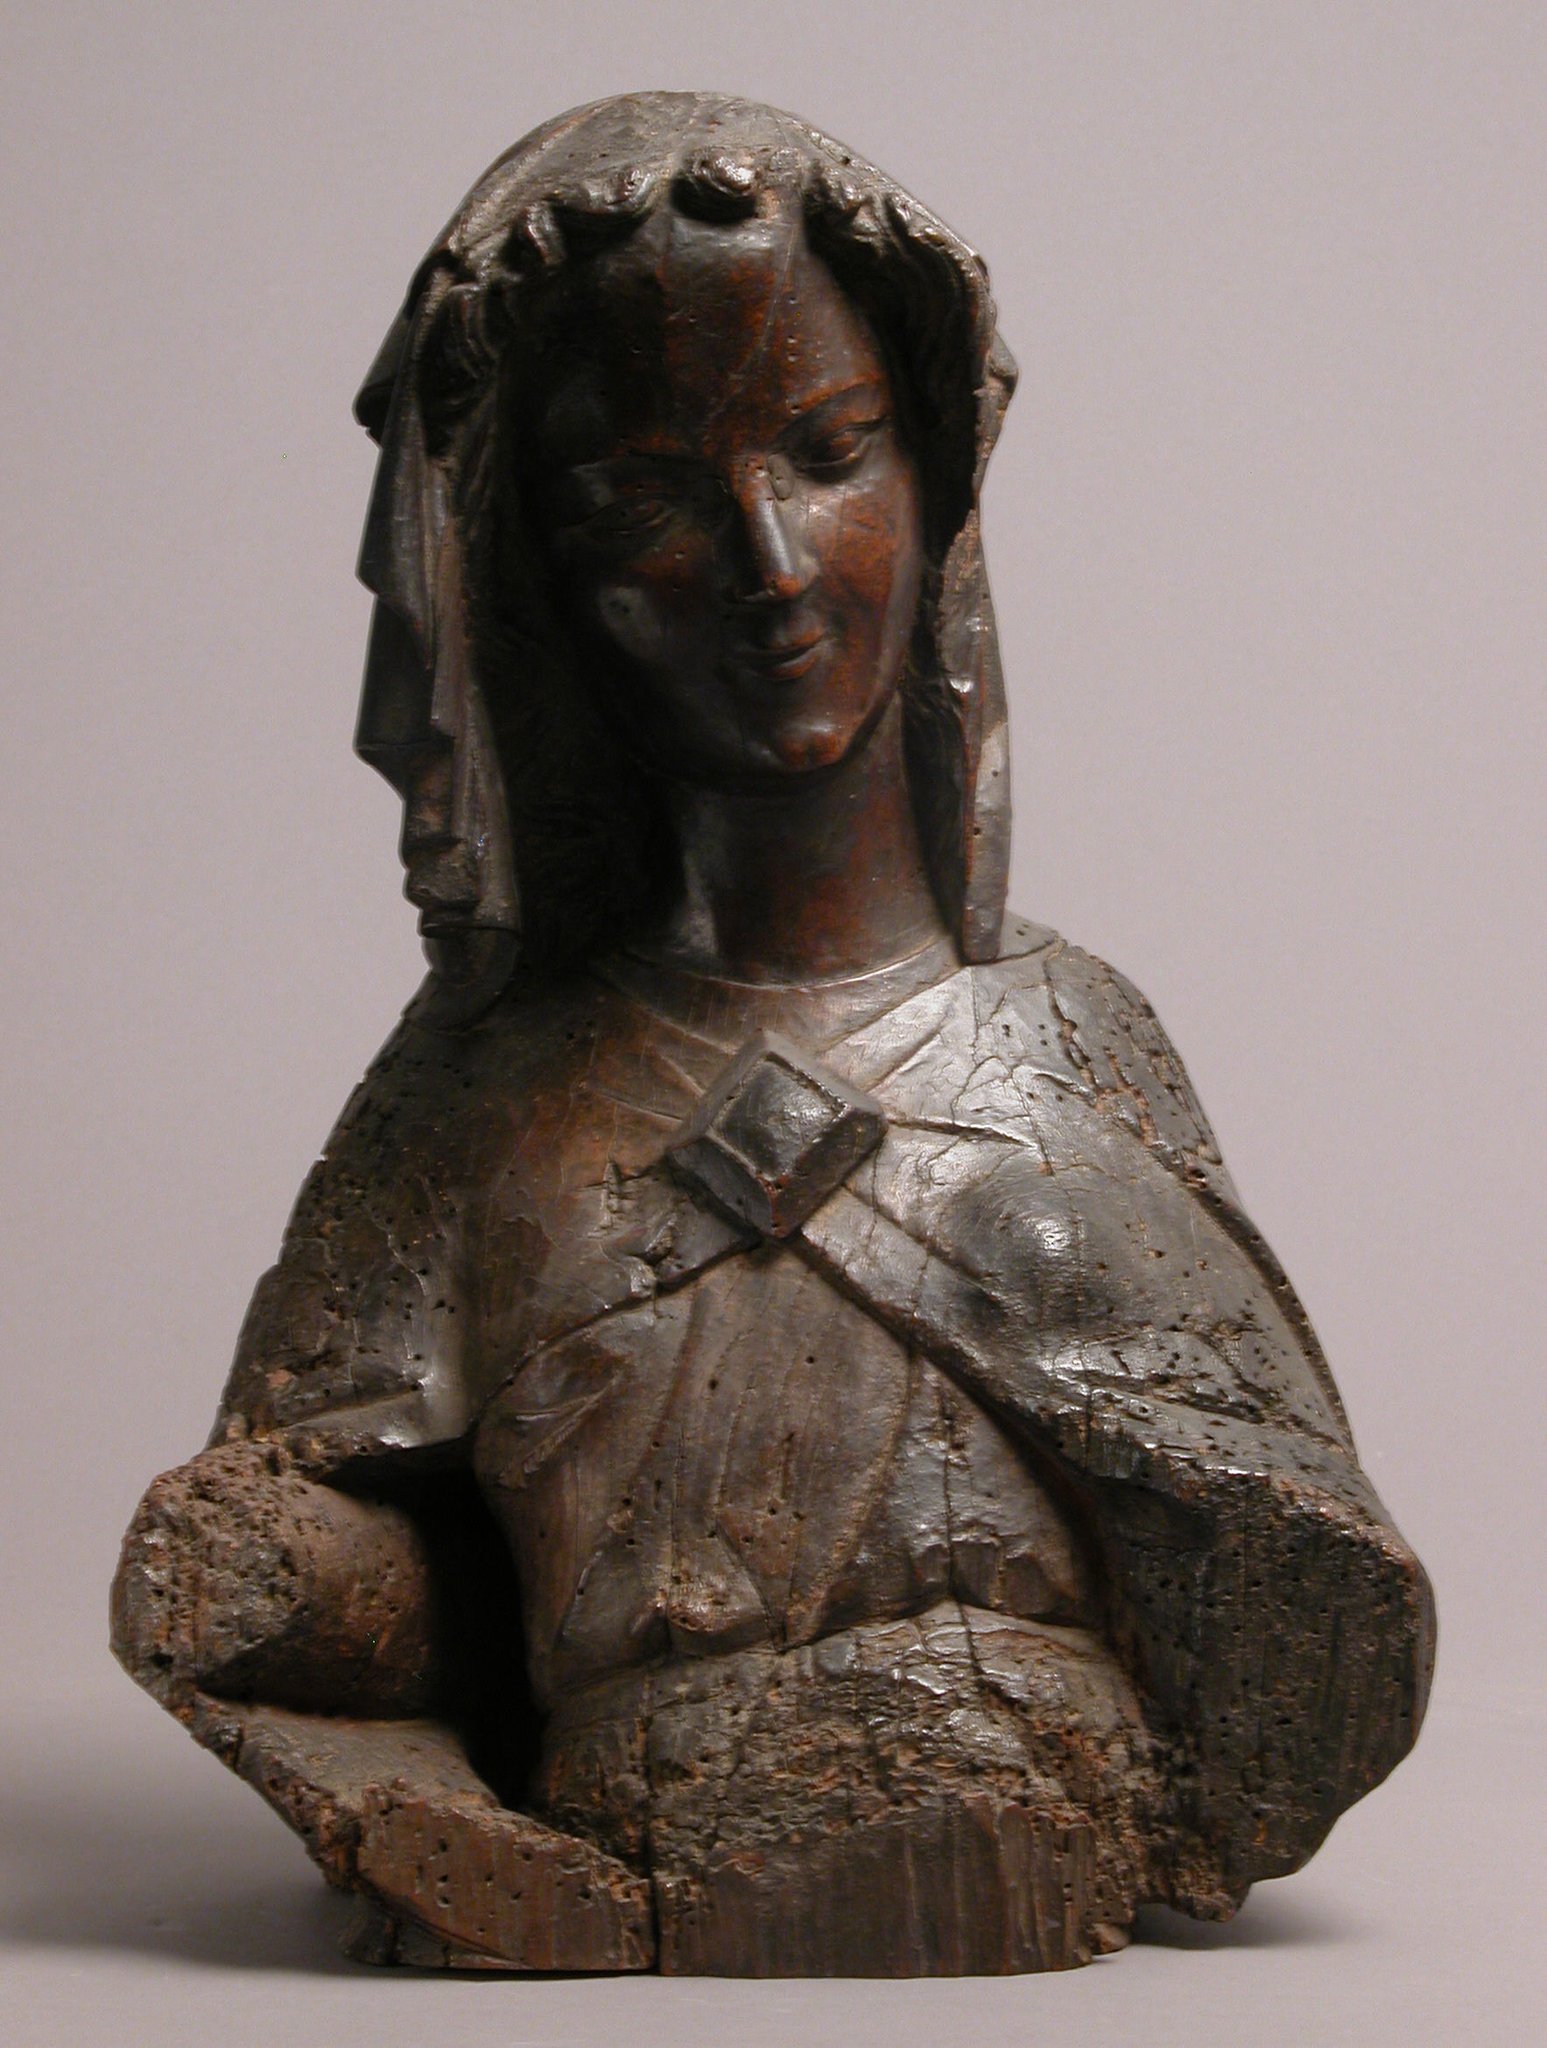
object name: bust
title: Bust of a Women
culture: french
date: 1301-1400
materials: wood